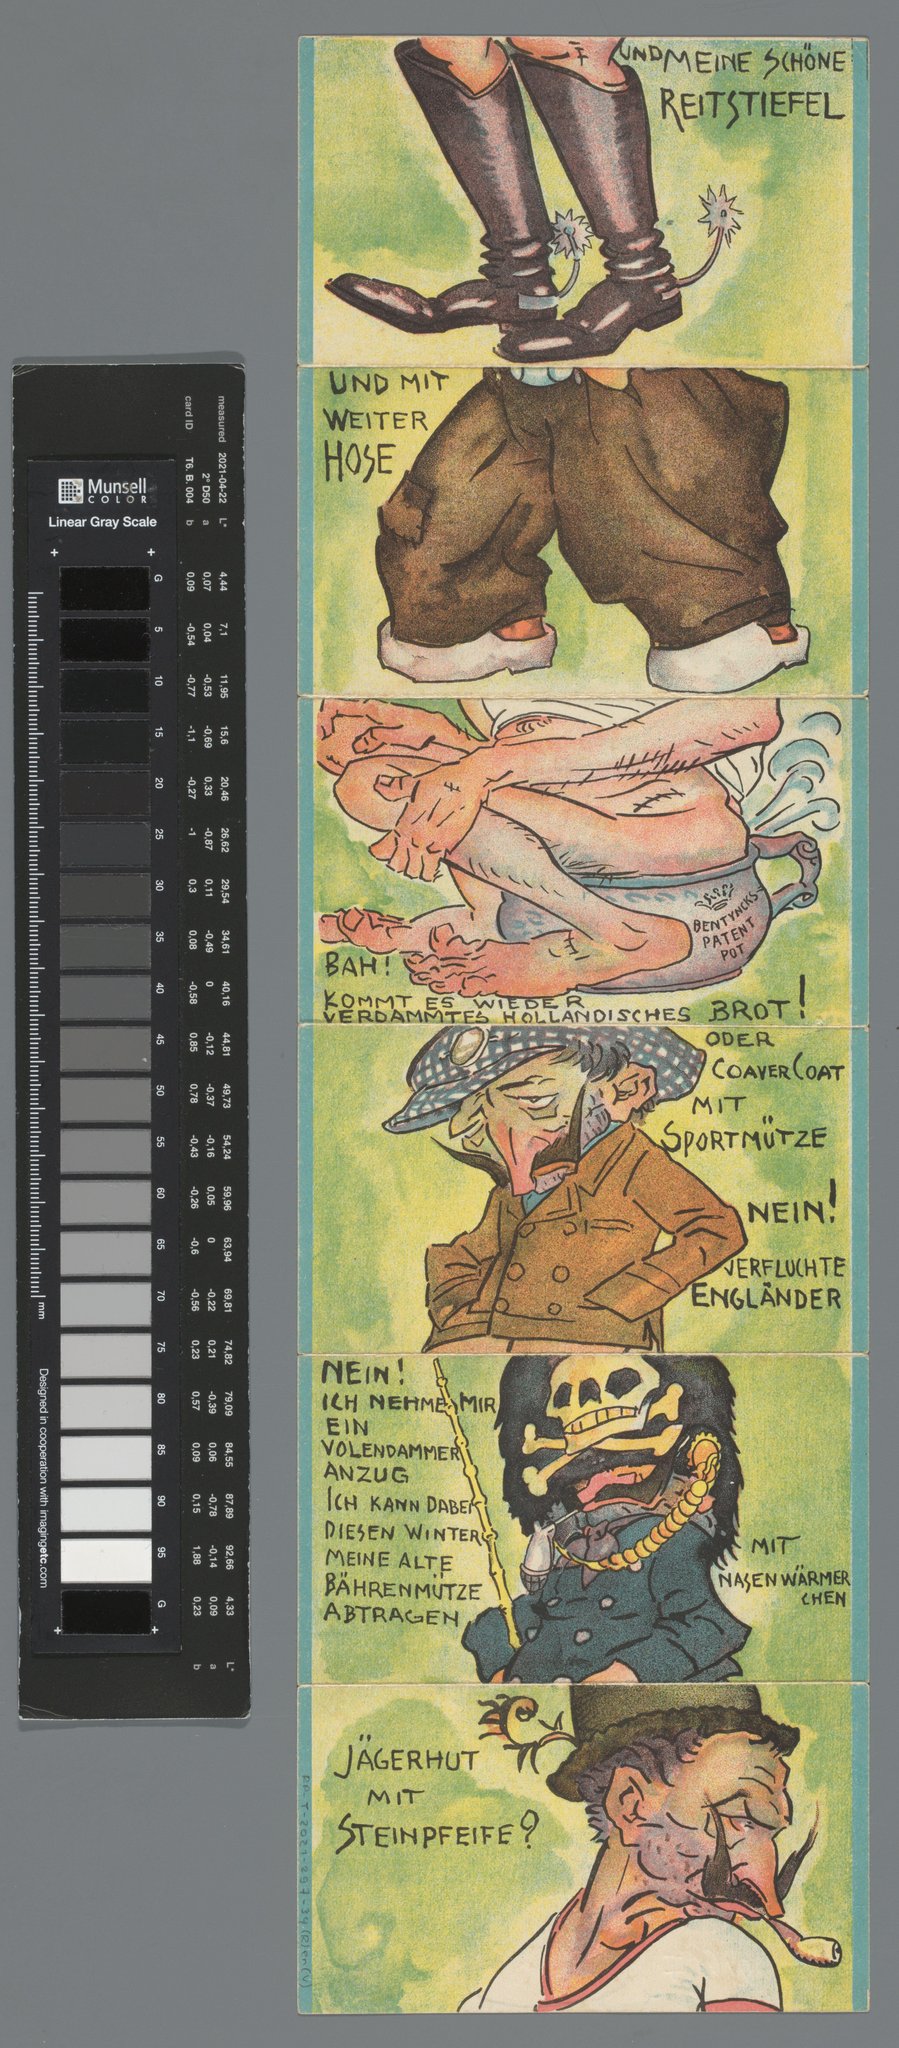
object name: print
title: Verschillende kledingstukken voor Keizer Wilhelm II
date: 1916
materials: paper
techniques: lithograph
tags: wilhelm ii (keizer van duitsland), head-gear, boots, clothes, costume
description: Karikaturale weergave van de kledingopties die Keizer Wilhelm II tot zijn beschikking heeft, waaronder rijlaarzen, broek, jagershoed en berenmuts. Prent maakt deel uit van een album.